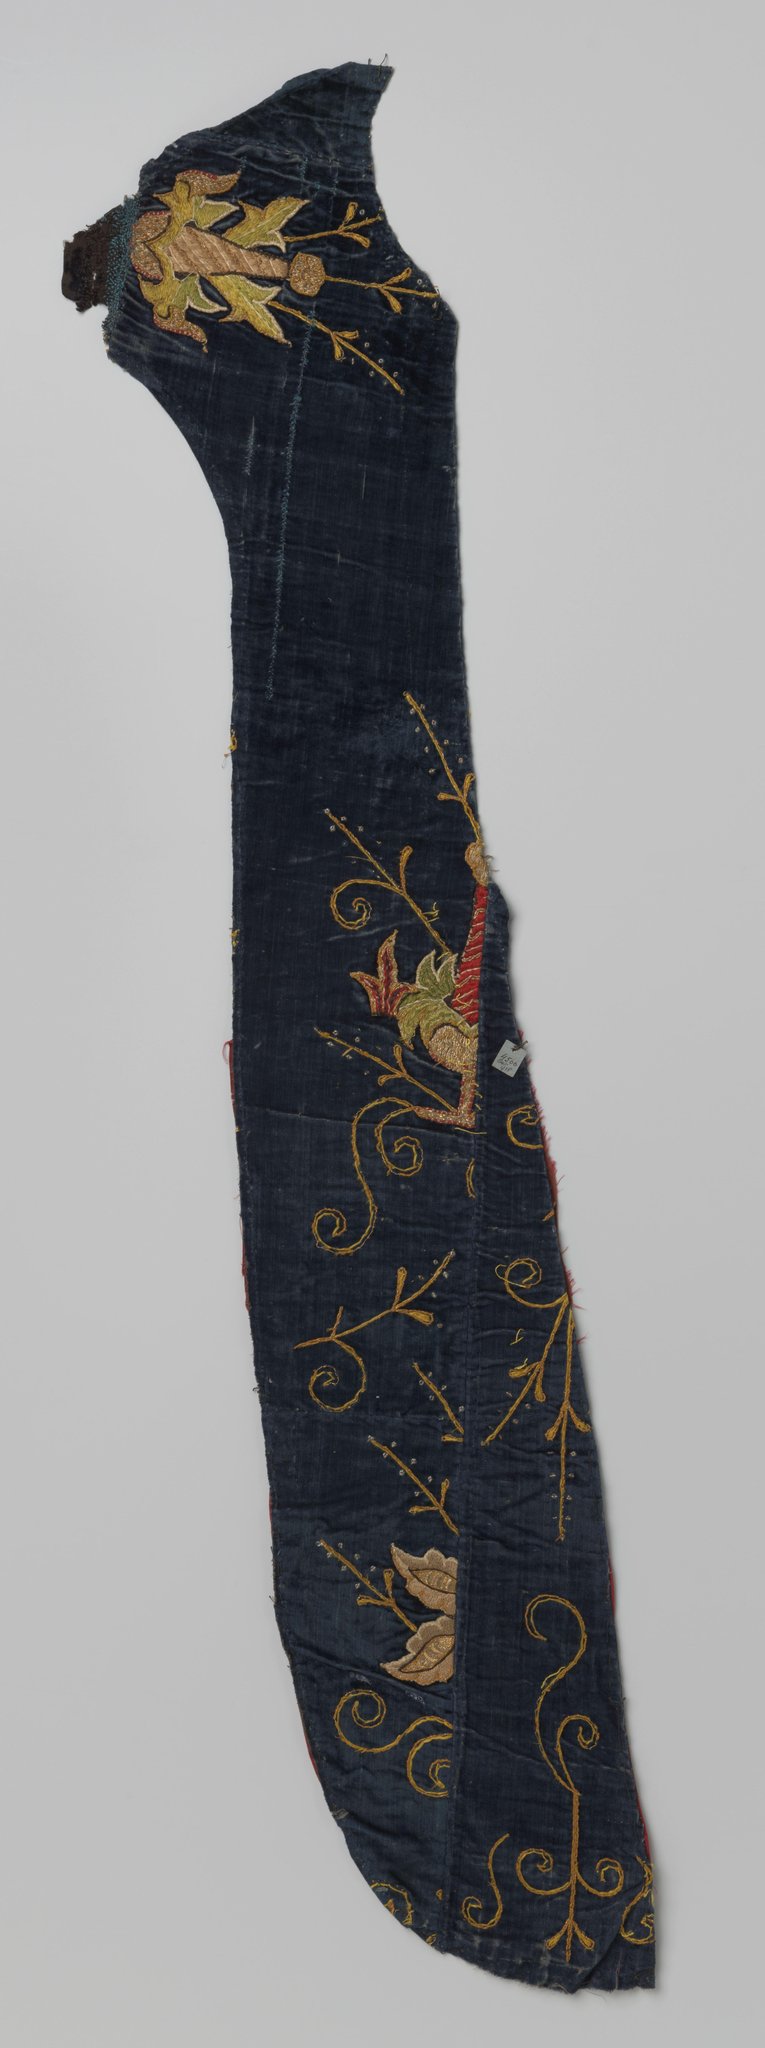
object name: fragment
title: Fragment van een kazuifel, met borduurwerk van zijde en goudraad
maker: Anonymous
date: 1500-1525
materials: gold thread, silk, velvet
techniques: embroidered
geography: netherlands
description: Fragment van een kazuifel, met borduurwerk. Het patroon heeft bloemen. De kazuifel is gemaakt van blauw fluweel.